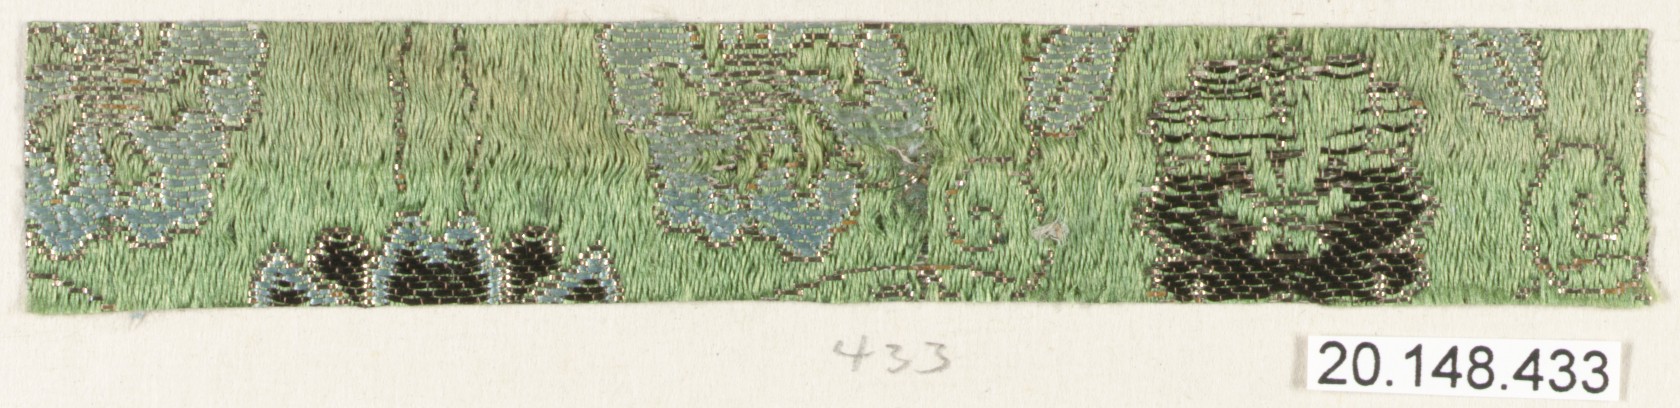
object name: piece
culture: japanese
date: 1701-1800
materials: silk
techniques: compound weave